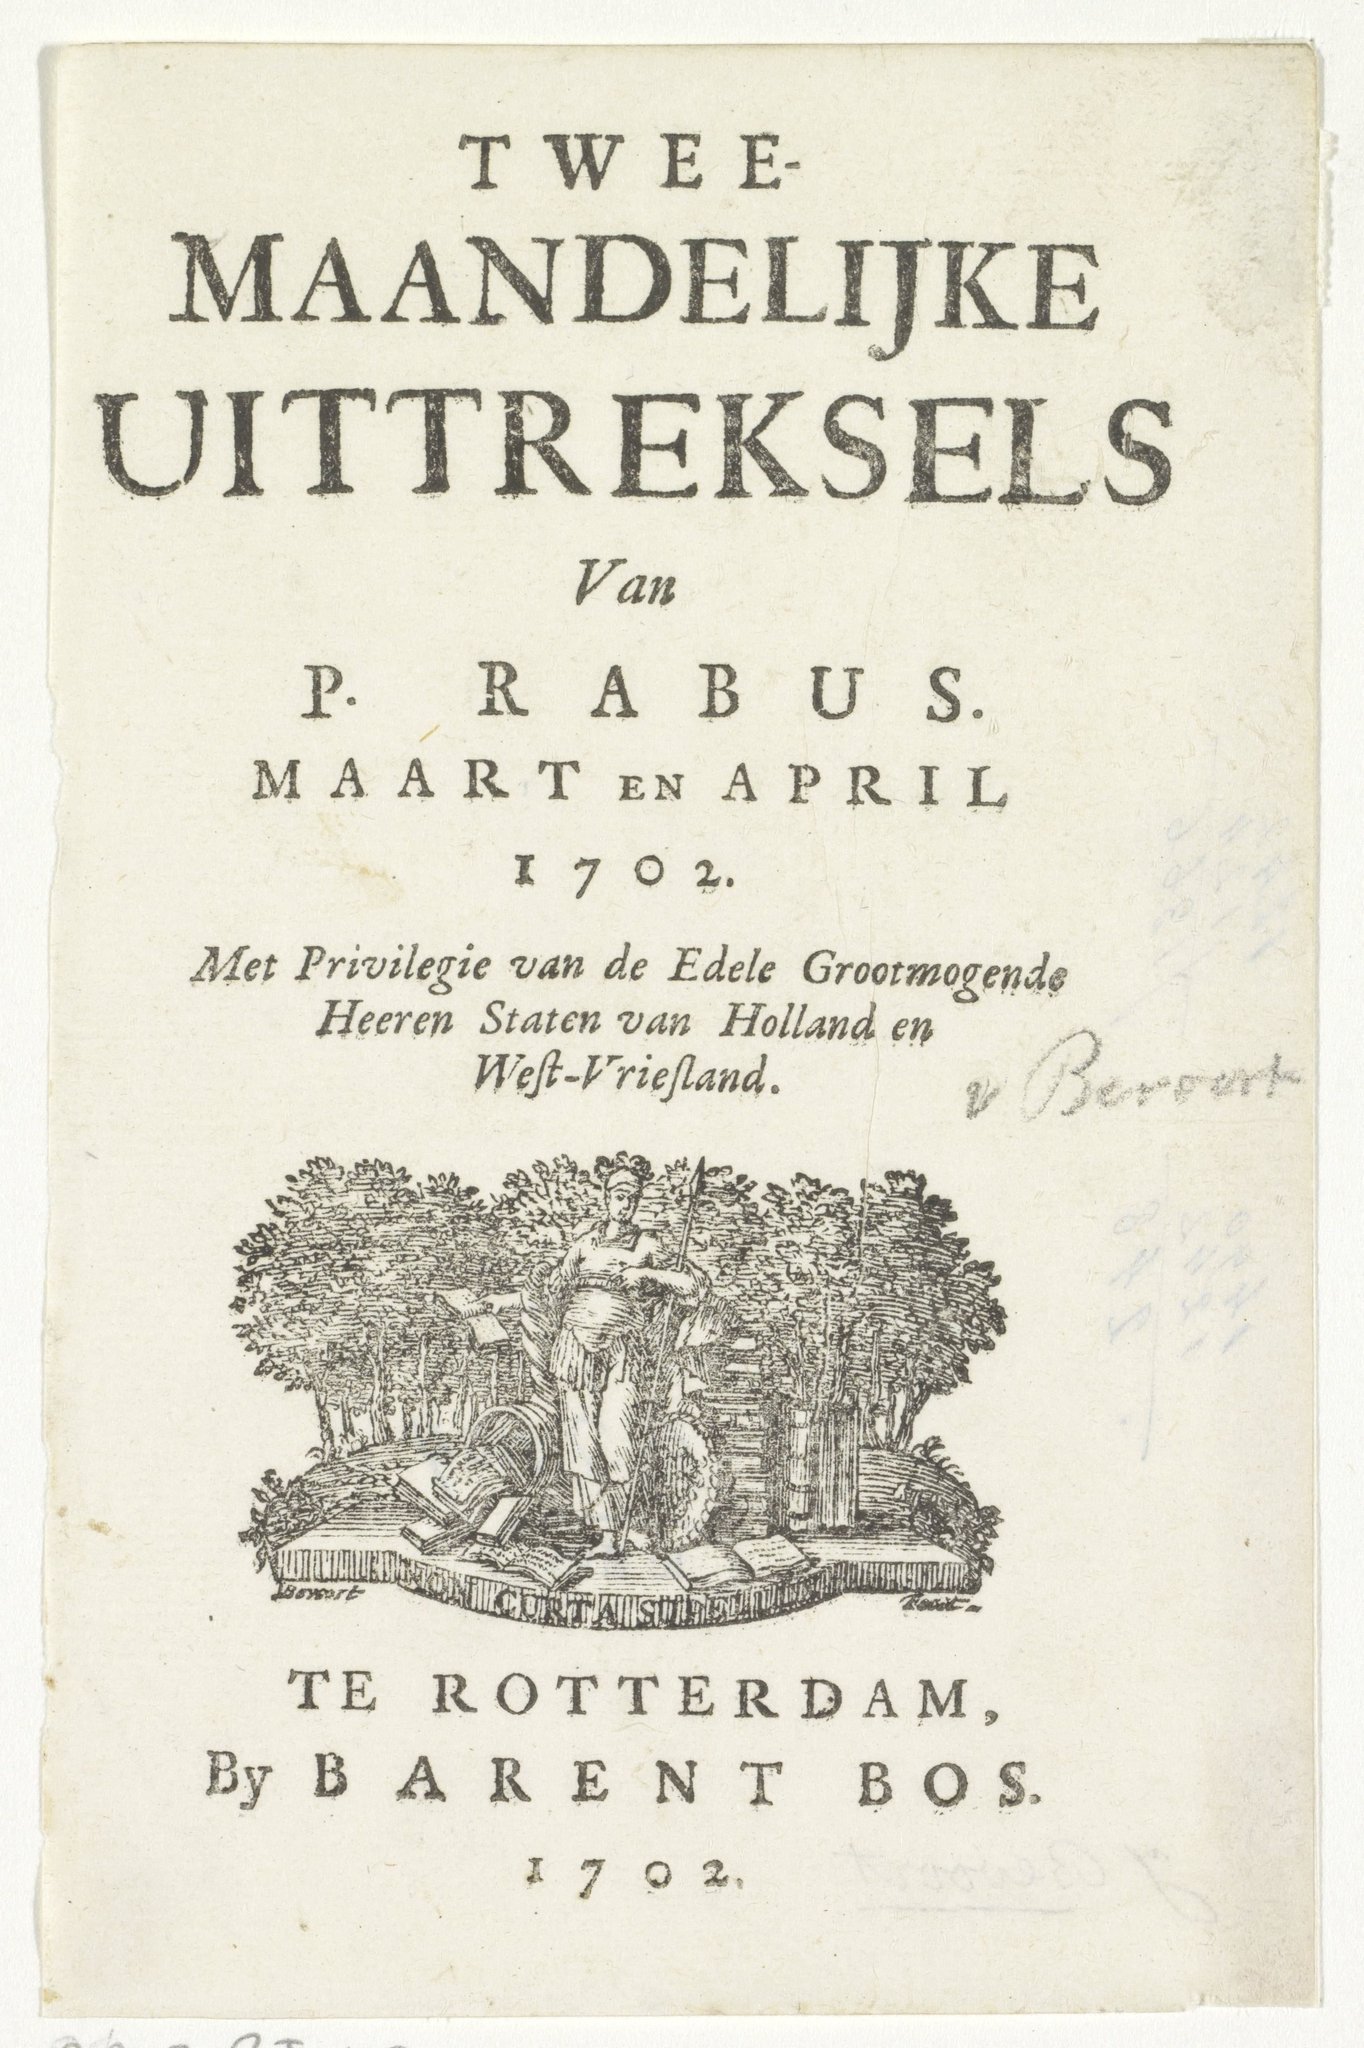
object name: book illustration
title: Titelvignet voor: Petrus Rabus, Twee-maandelijke uittreksels, 1702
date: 1702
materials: paper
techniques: letterpress printing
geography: netherlands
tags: vignette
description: Titelvignet voor: Rabus, Petrus. Twee-maandelijke uittreksels. Rotterdam: Barent Bos, 1702.